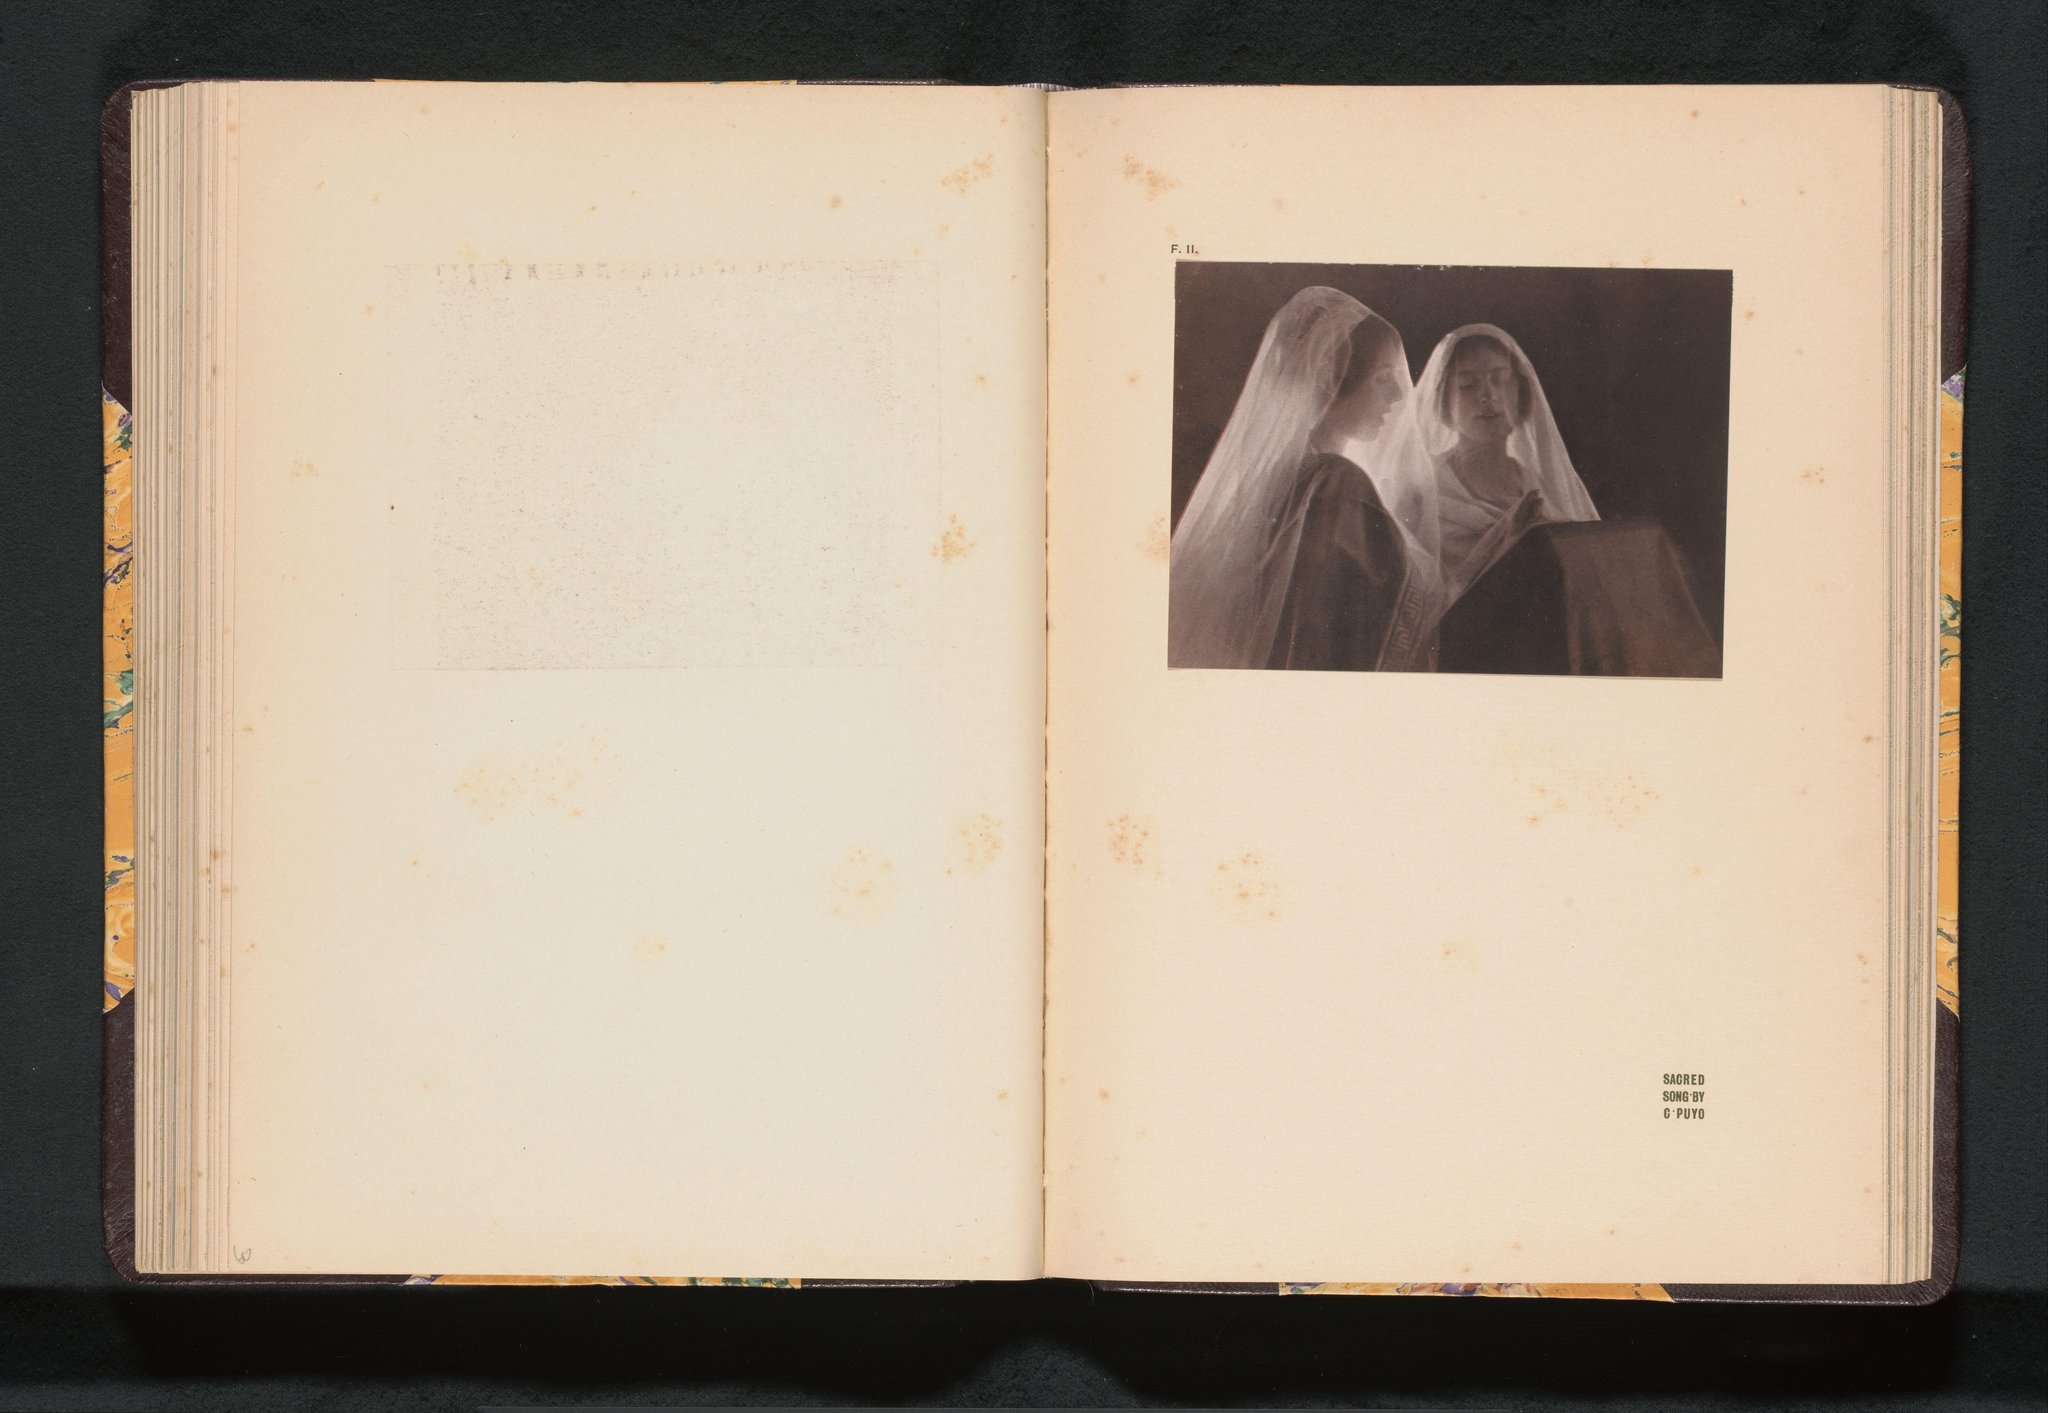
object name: page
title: Twee zingende vrouwen met sluier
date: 1900-1905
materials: paper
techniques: two-color autotype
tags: singing of psalms, hymns, etc., adult woman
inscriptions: inscription: ‘F. II.’, inscription: ‘Sacred song by C. Puyo’